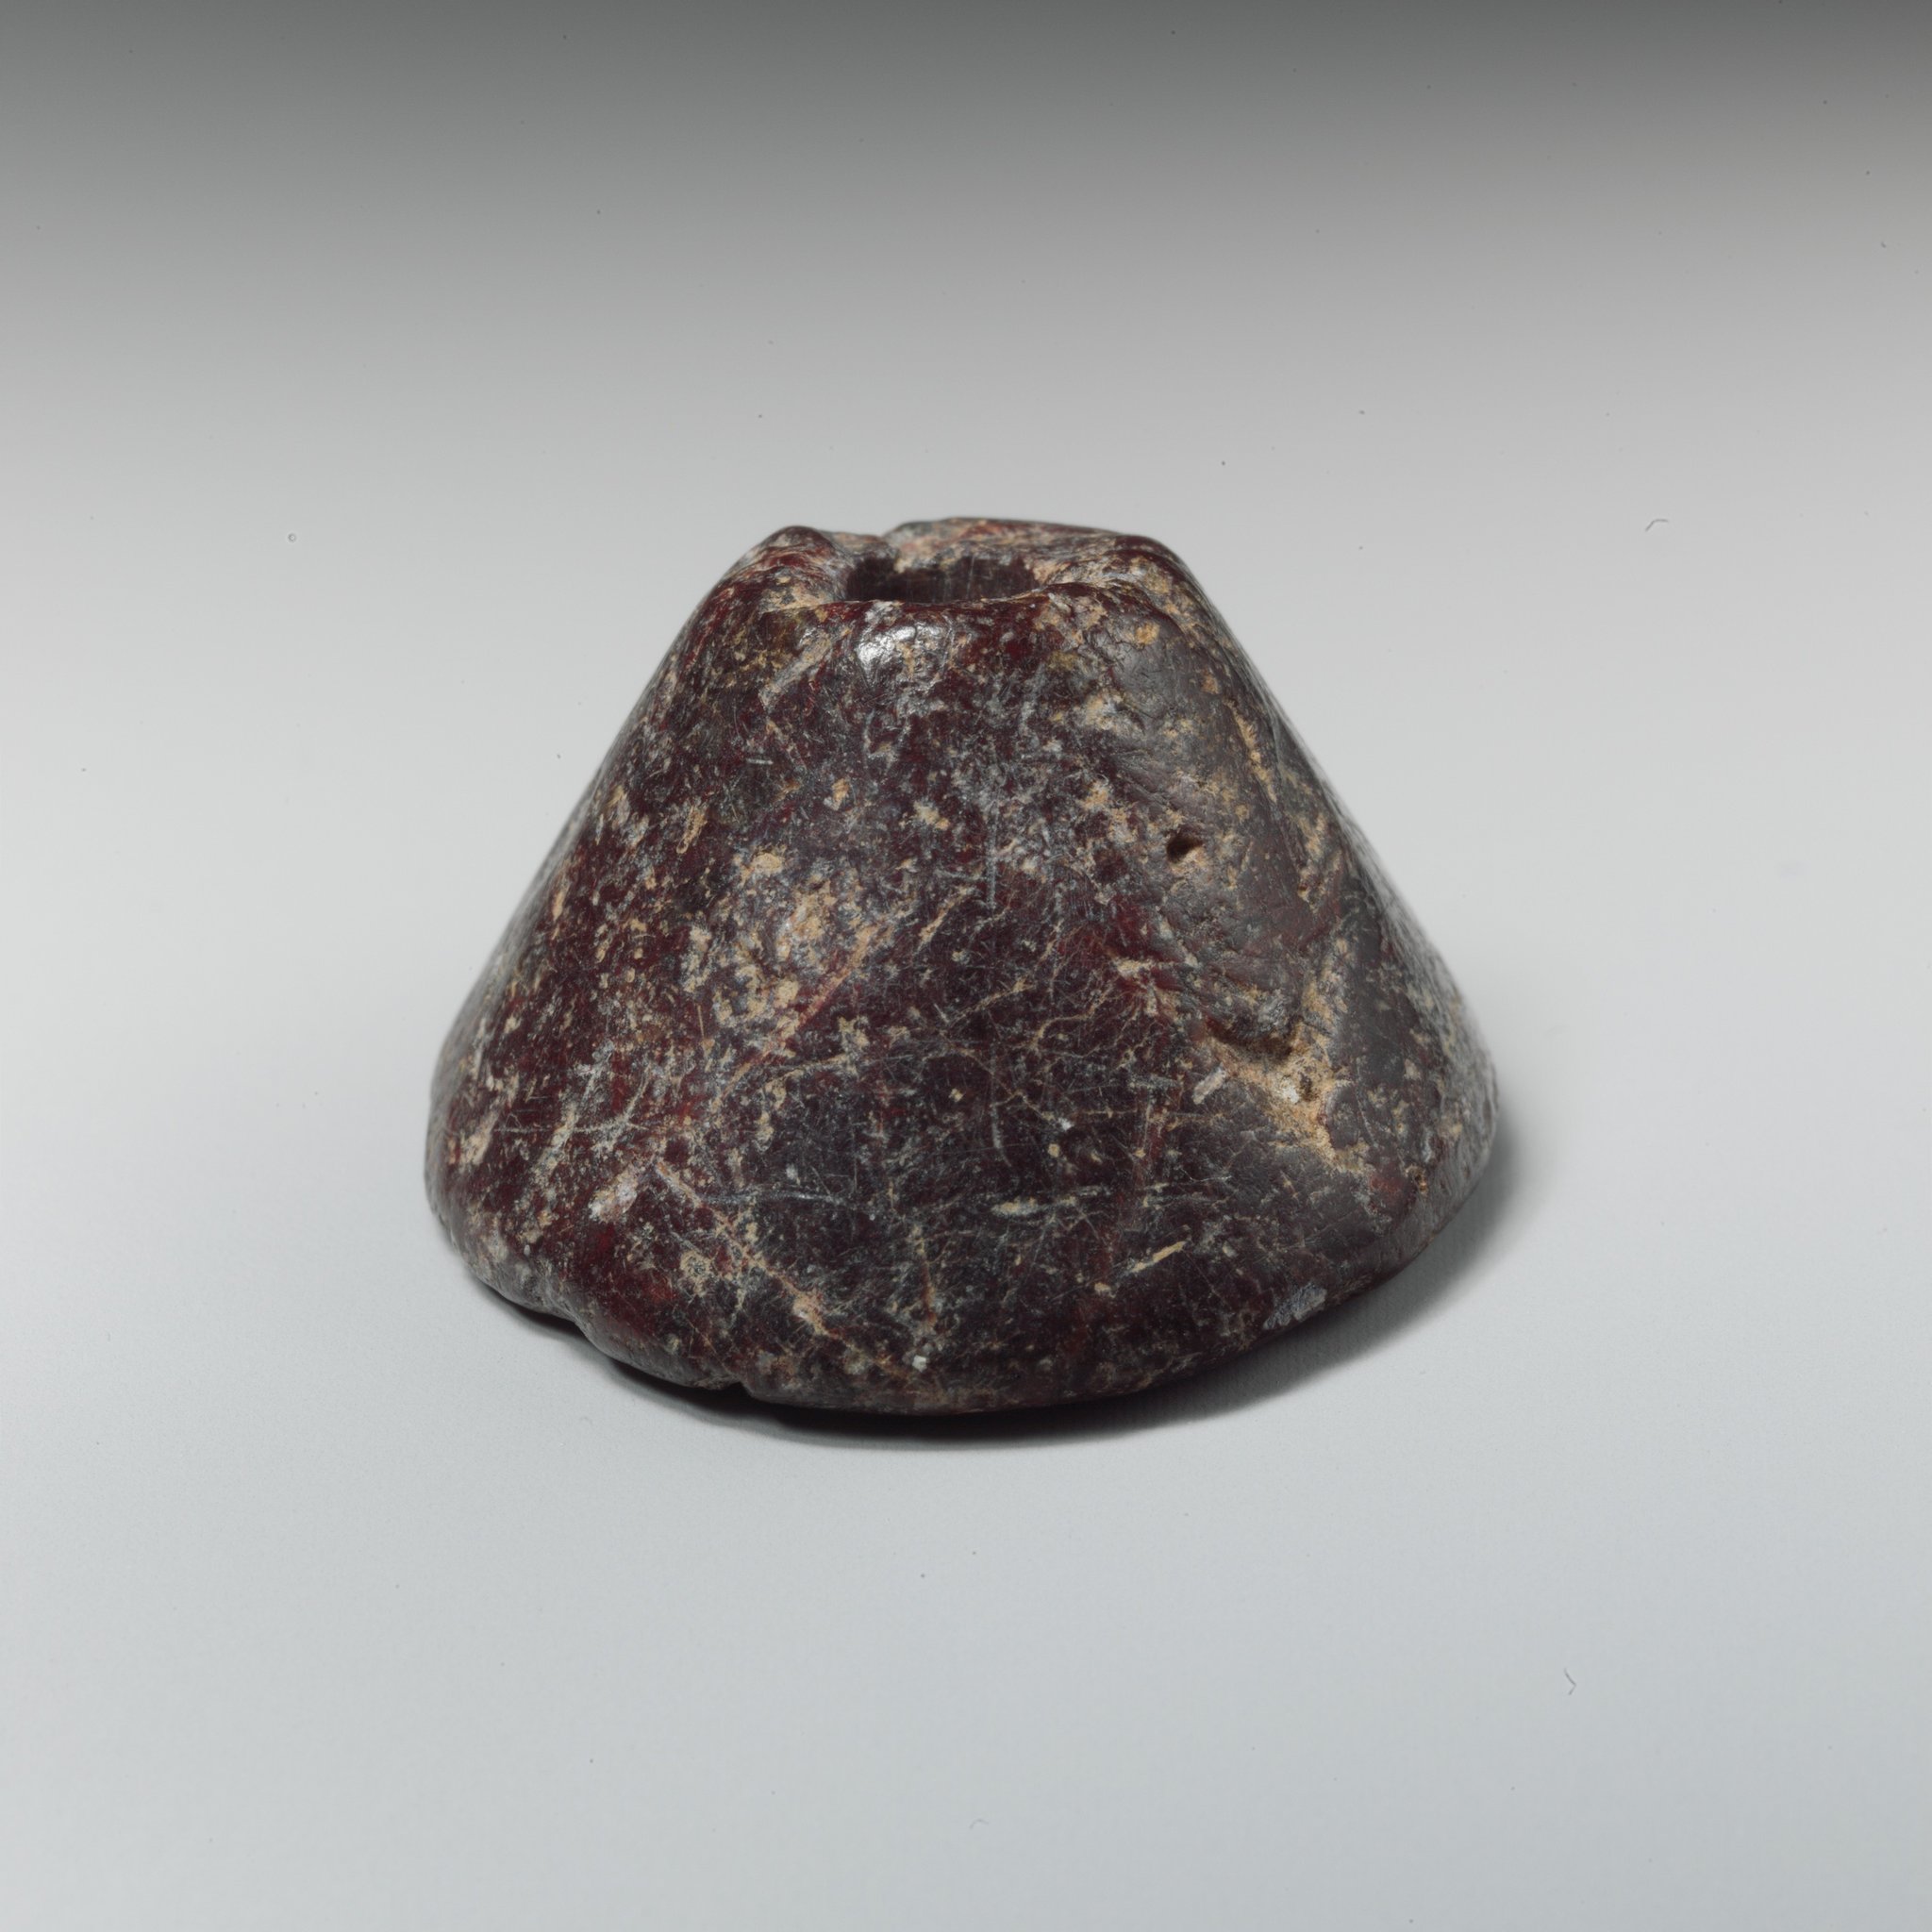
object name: spindle whorl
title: Stone spindle whorl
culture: minoan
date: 2400-1900 BCE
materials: stone